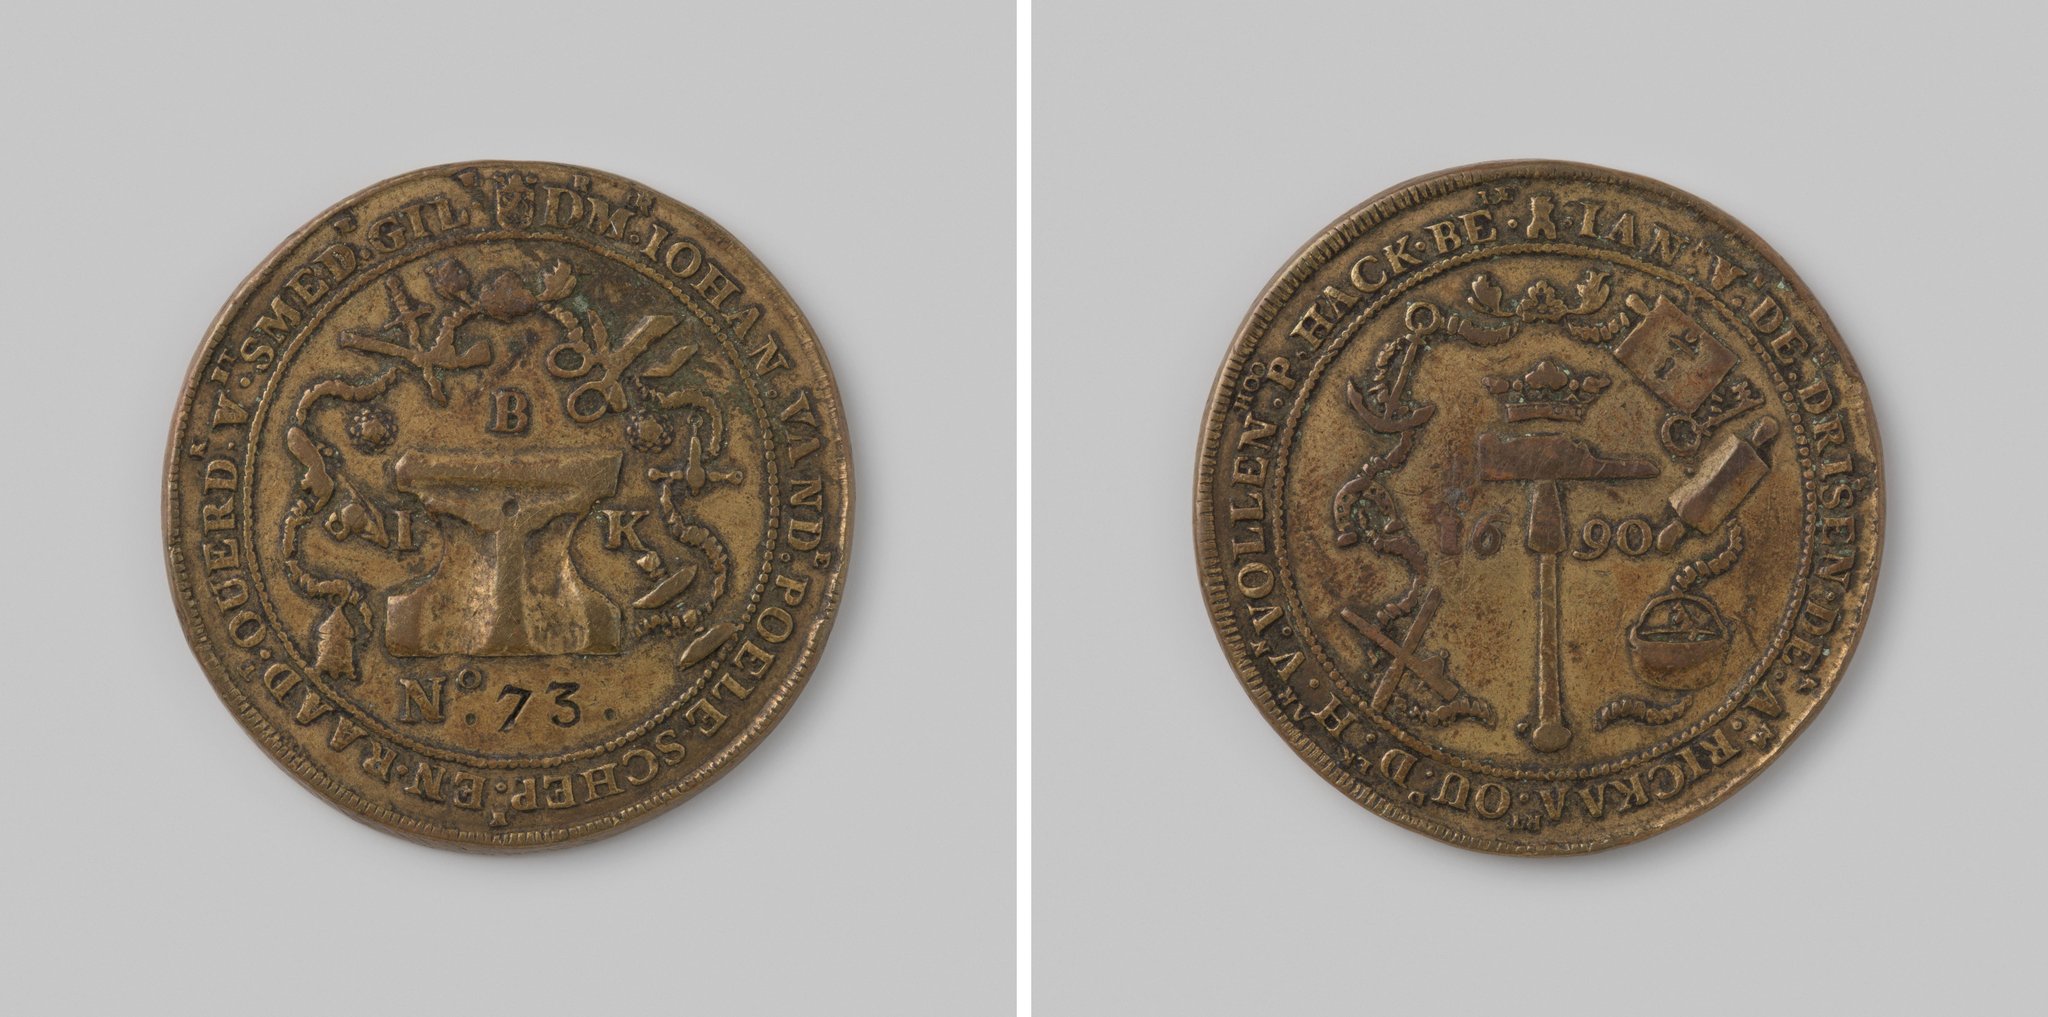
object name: presentiepenning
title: Gildepenning (presentiepenning) van het Smedengilde te Middelburg.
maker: willem du pre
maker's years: 1687-1722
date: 1690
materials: brass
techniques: striking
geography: middelburg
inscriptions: circumscription: ‘(wapenschildje Zeeland) DR MR IOHAN VAN DE POELE SCHEPN EN RAADT OUERDK VHT SMEDE GILT’, inscription: ‘.73.’, circumscription: ‘(burcht) IANS VN DEN DRISSEN DEK AM RICAART OUD DEK HAR VN VOLLENHOO P HACK BELE’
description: Gegoten messing penning, op de voorzijde een aambeeld tussen de letters IBK, omringd door een ketting behangen met diverse metaalwaren, onderaan N° waarachter gegraveerd het getal 73, met omschrift, op de keerzijde een gekroonde hamer tussen 16 - 90, omringd door een zelfde ketting, met omschrift